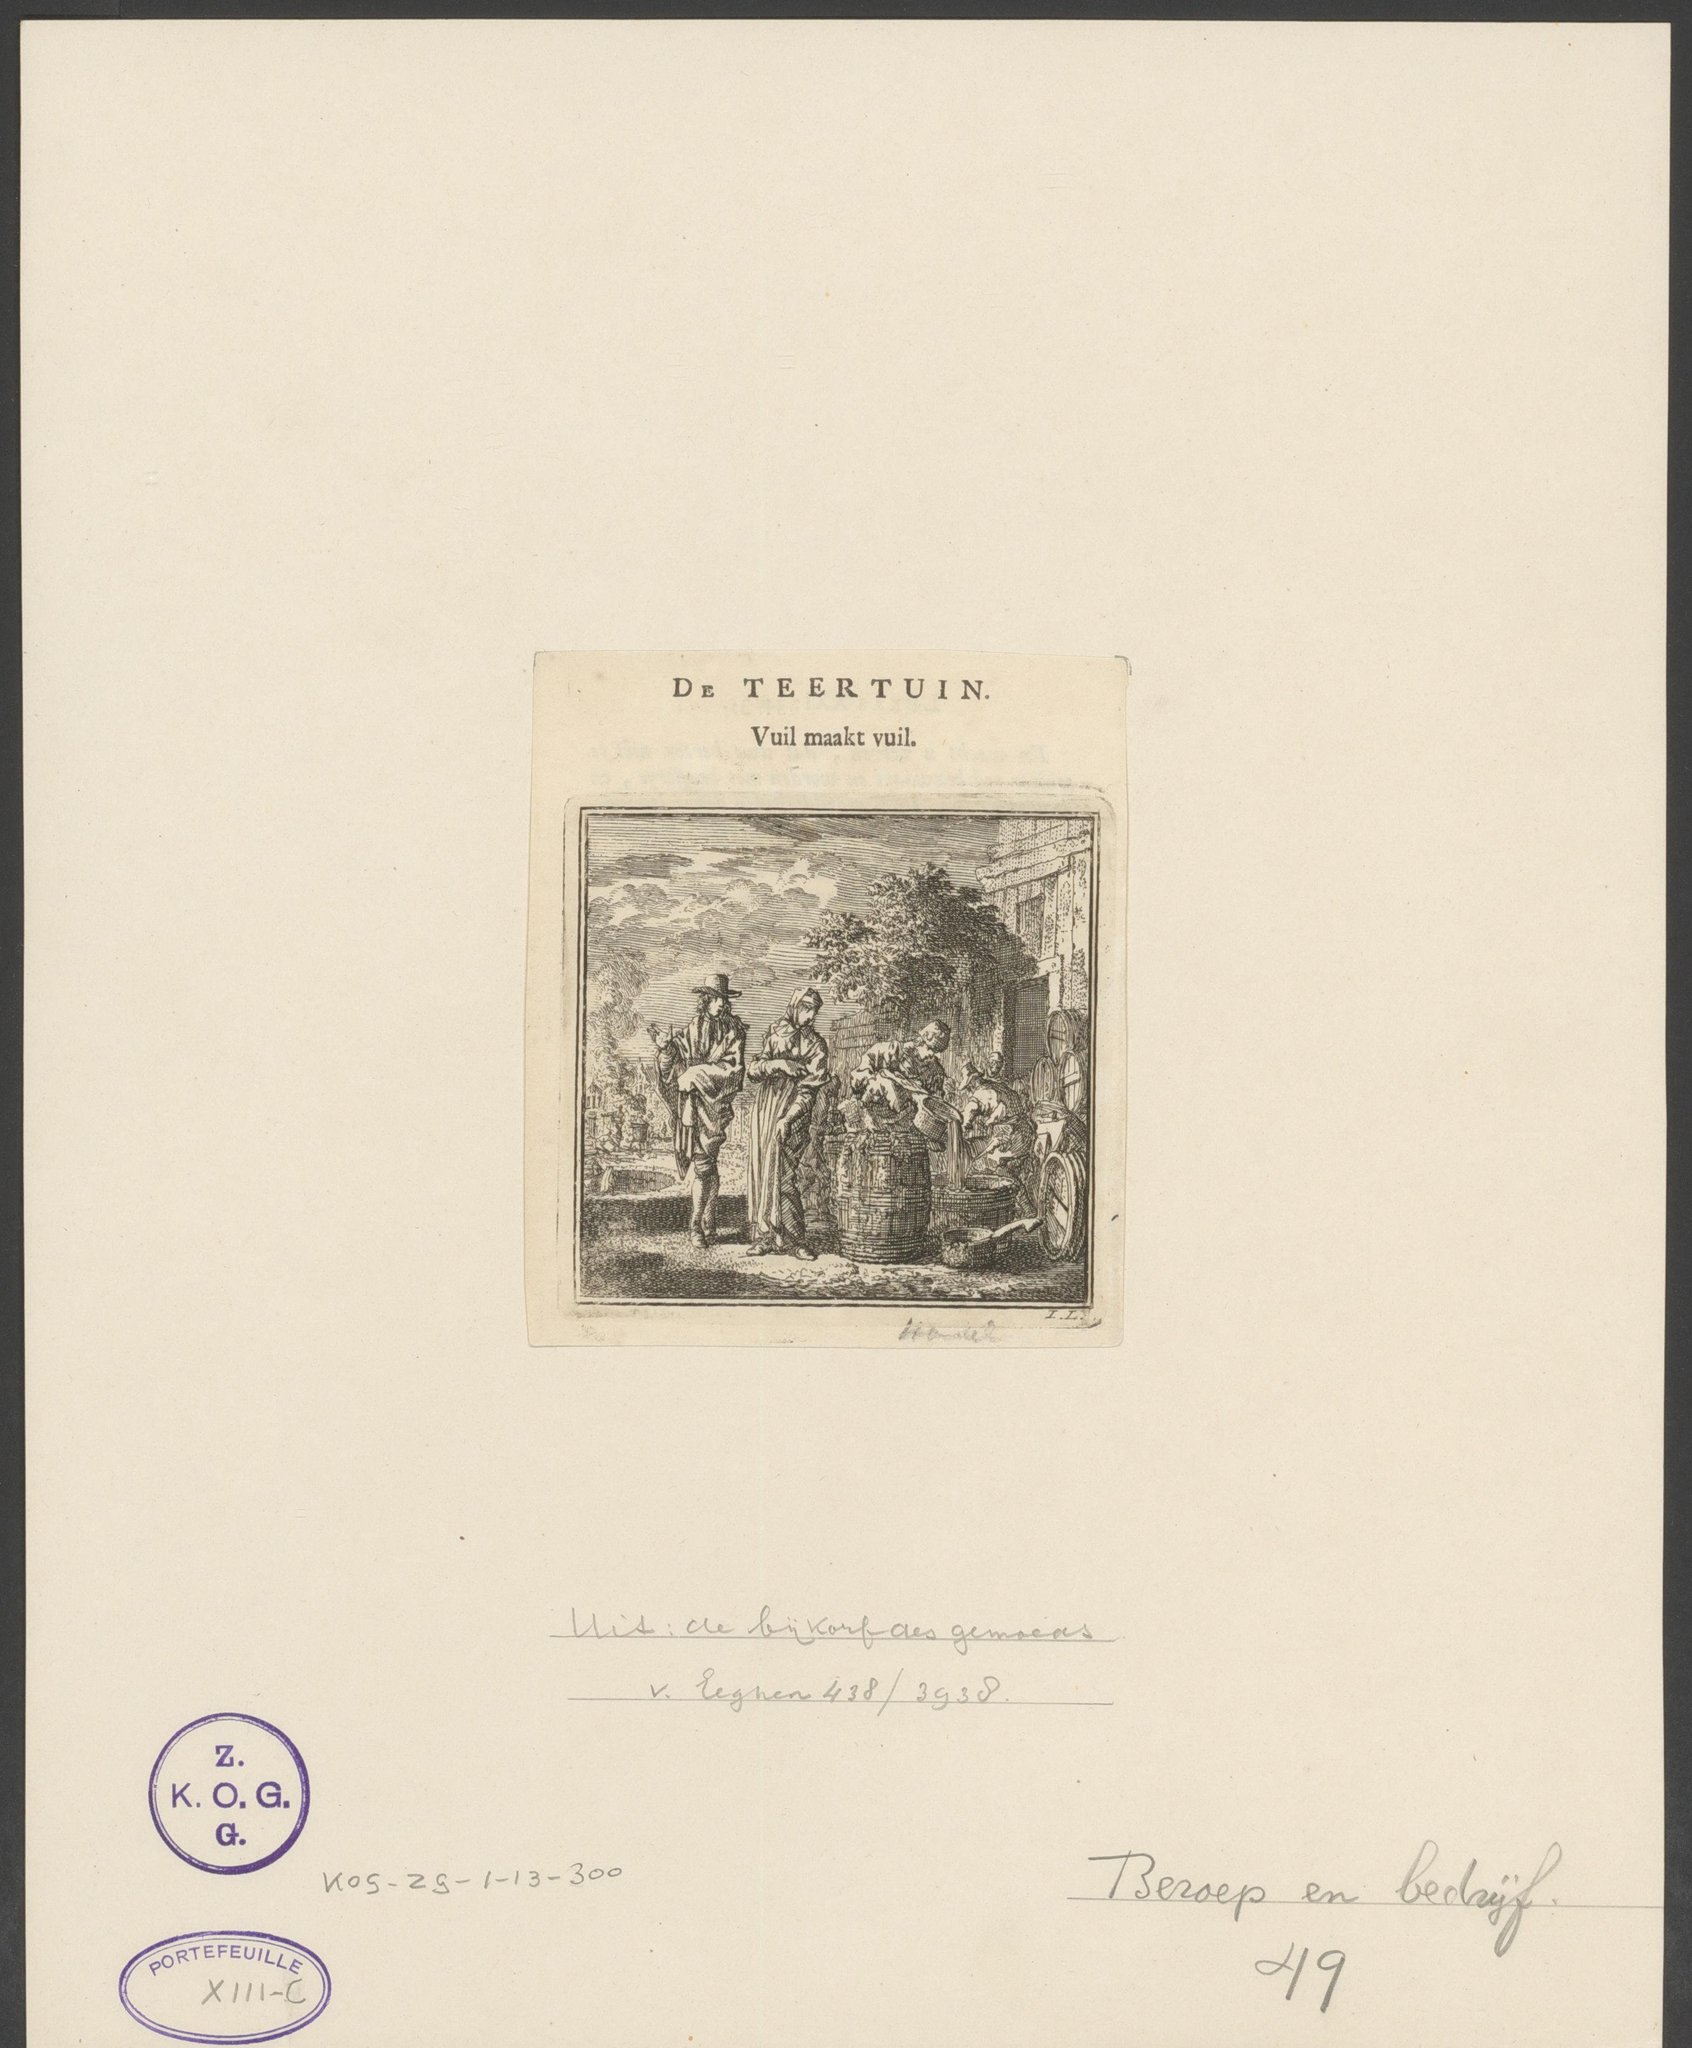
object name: book illustration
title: Teertuin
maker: jan luyken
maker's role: draughtsman, print maker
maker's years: 1649-1712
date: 1711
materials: paper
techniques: etching, letterpress printing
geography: amsterdam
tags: handicrafts, craftsman at work, other handicrafts ~ wood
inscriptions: stamp, collector's mark: Lugt 1641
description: In de teertuin verkochten de teerkopers hun waren. Onderwerpsrubrieken binnen de Atlas Zeden en Gewoonten: Handel, Nijverheid en verkeer, Beroep en bedrijf, Mannelijk, Bewerkers van het hout.